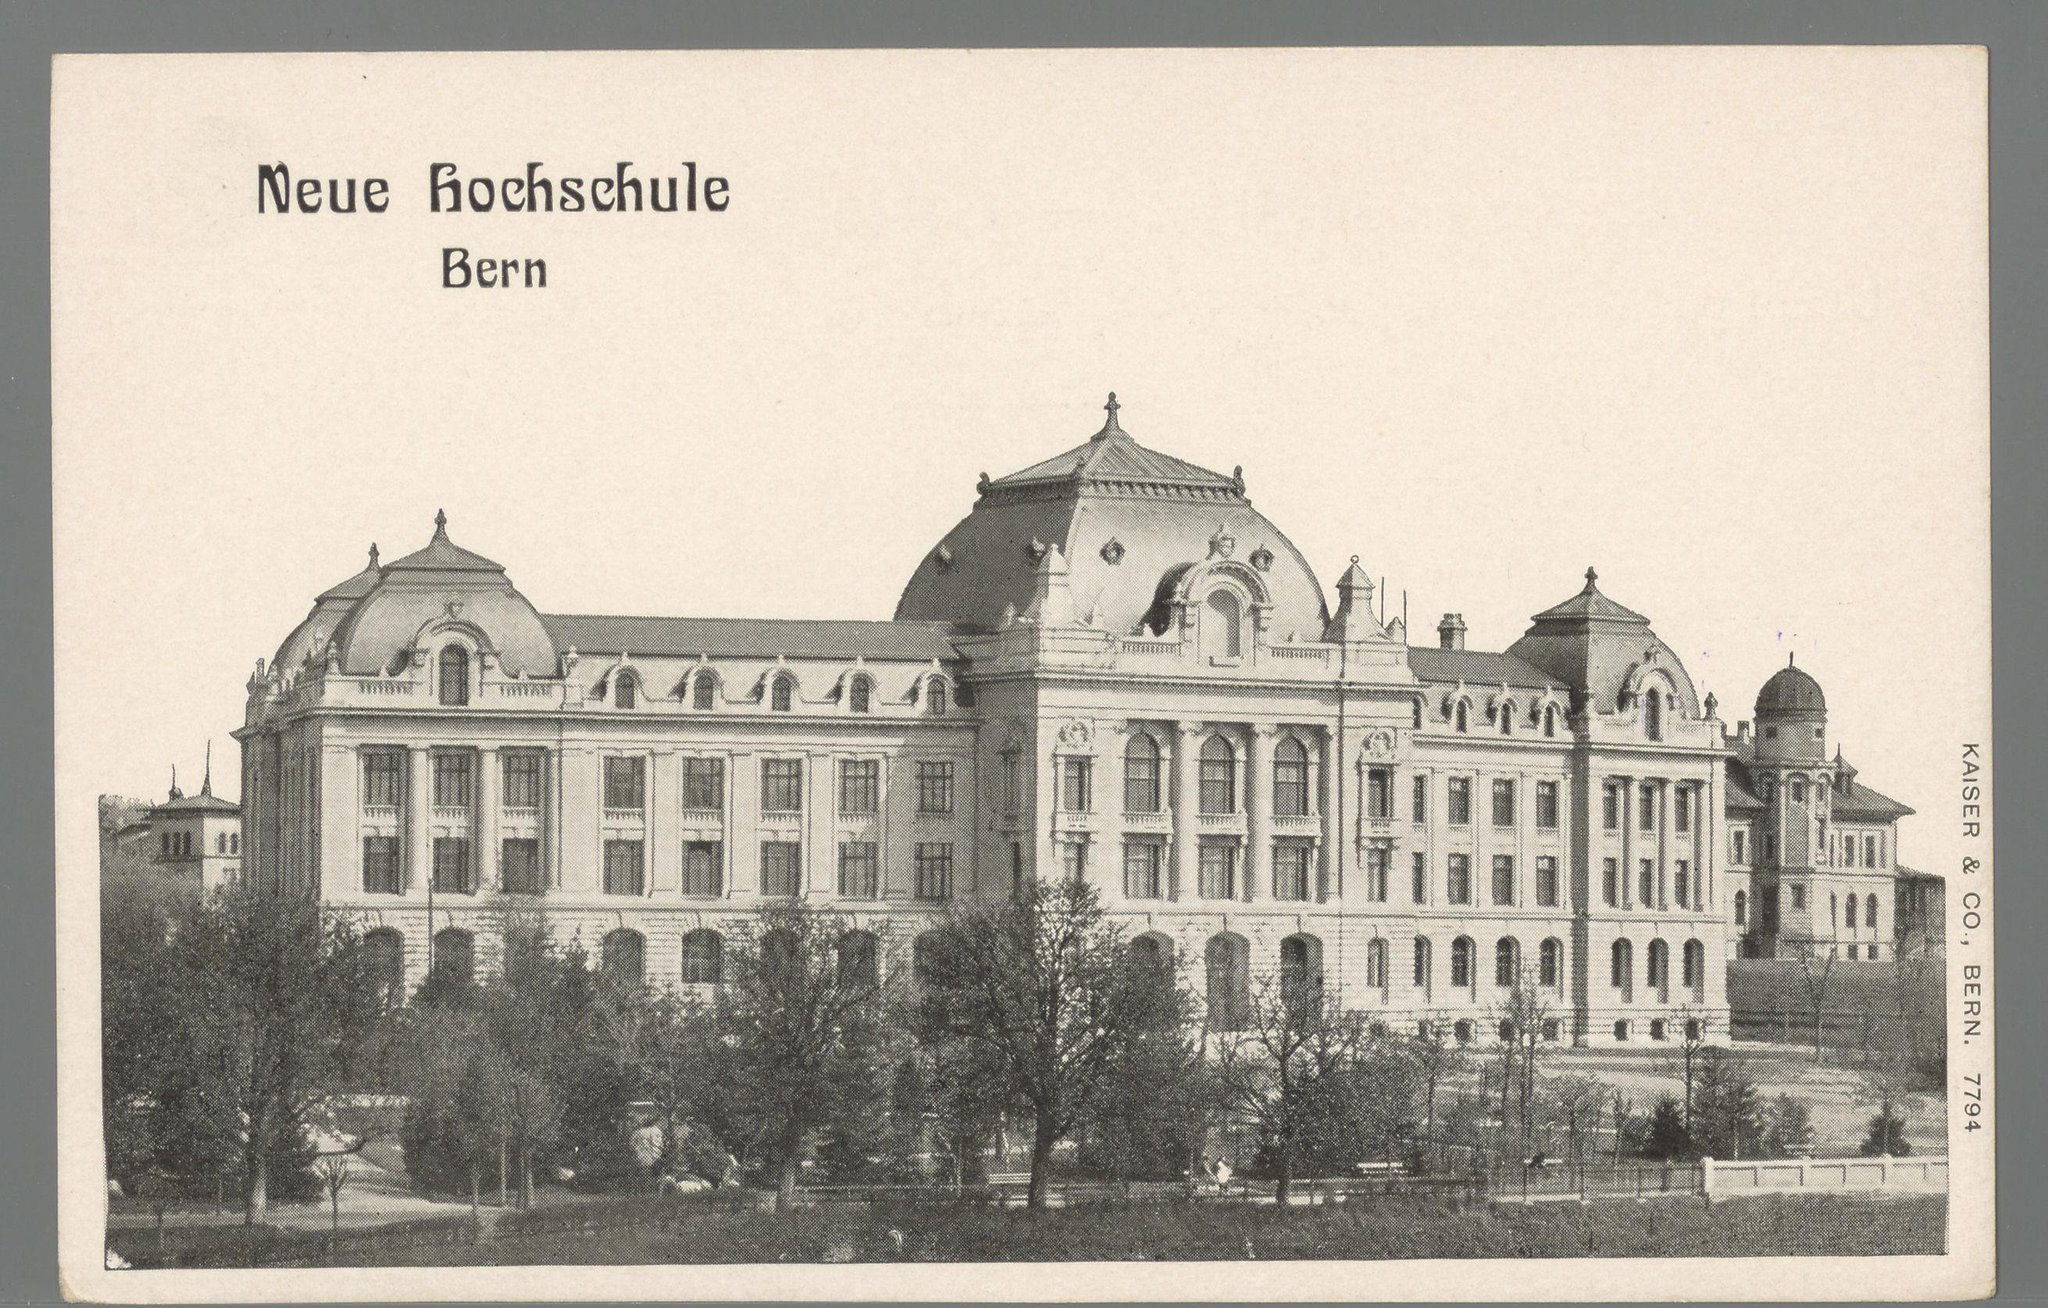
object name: photomechanical print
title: Neue Hochschule, Bern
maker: Anonymous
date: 1903-1904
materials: cardboard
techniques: autotype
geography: bern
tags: university (+ building ~ education, tuition), edifice, e.g.: public building, department store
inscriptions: stamp: ‘Congrès International de l'enseignement du dessin. 3 aout 1904. Berne 1904’